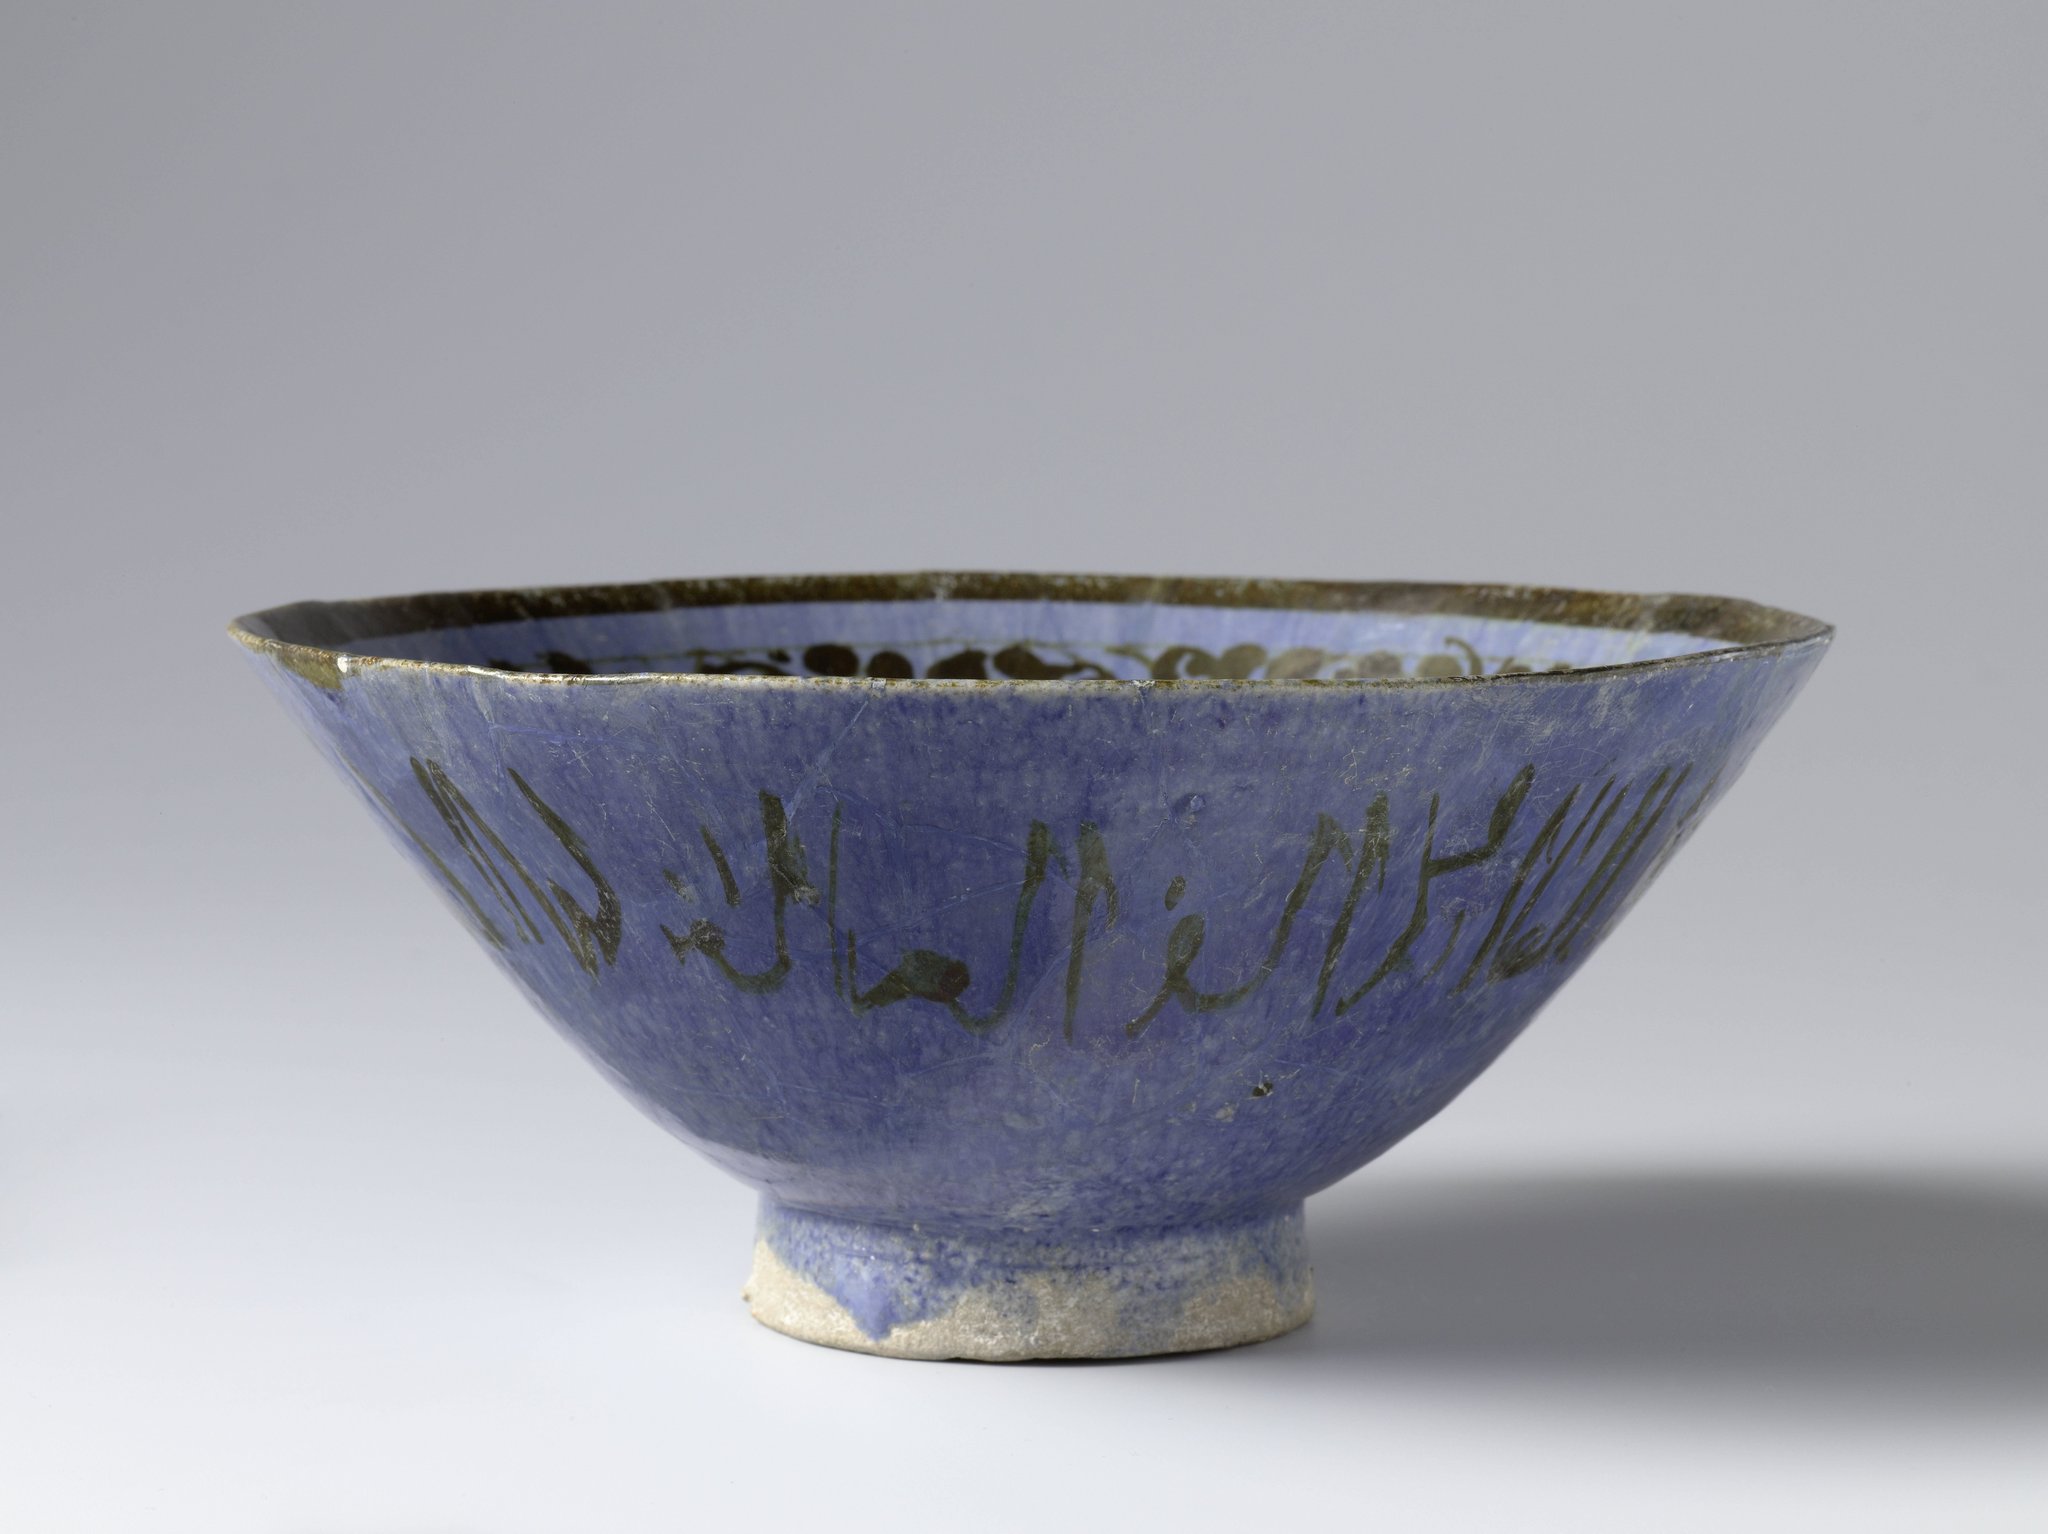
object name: bowl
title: Bowl with inscription borders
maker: Anonymous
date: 1170-1200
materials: earthenware, glaze, luster, paint, quartz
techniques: firing, turning, vitrification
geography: kashan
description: Kom van kwarts-fritgoed bedekt met een monochroom blauw alkaliglazuur waarop banden met een opschrift in een Arabische taal in luster.